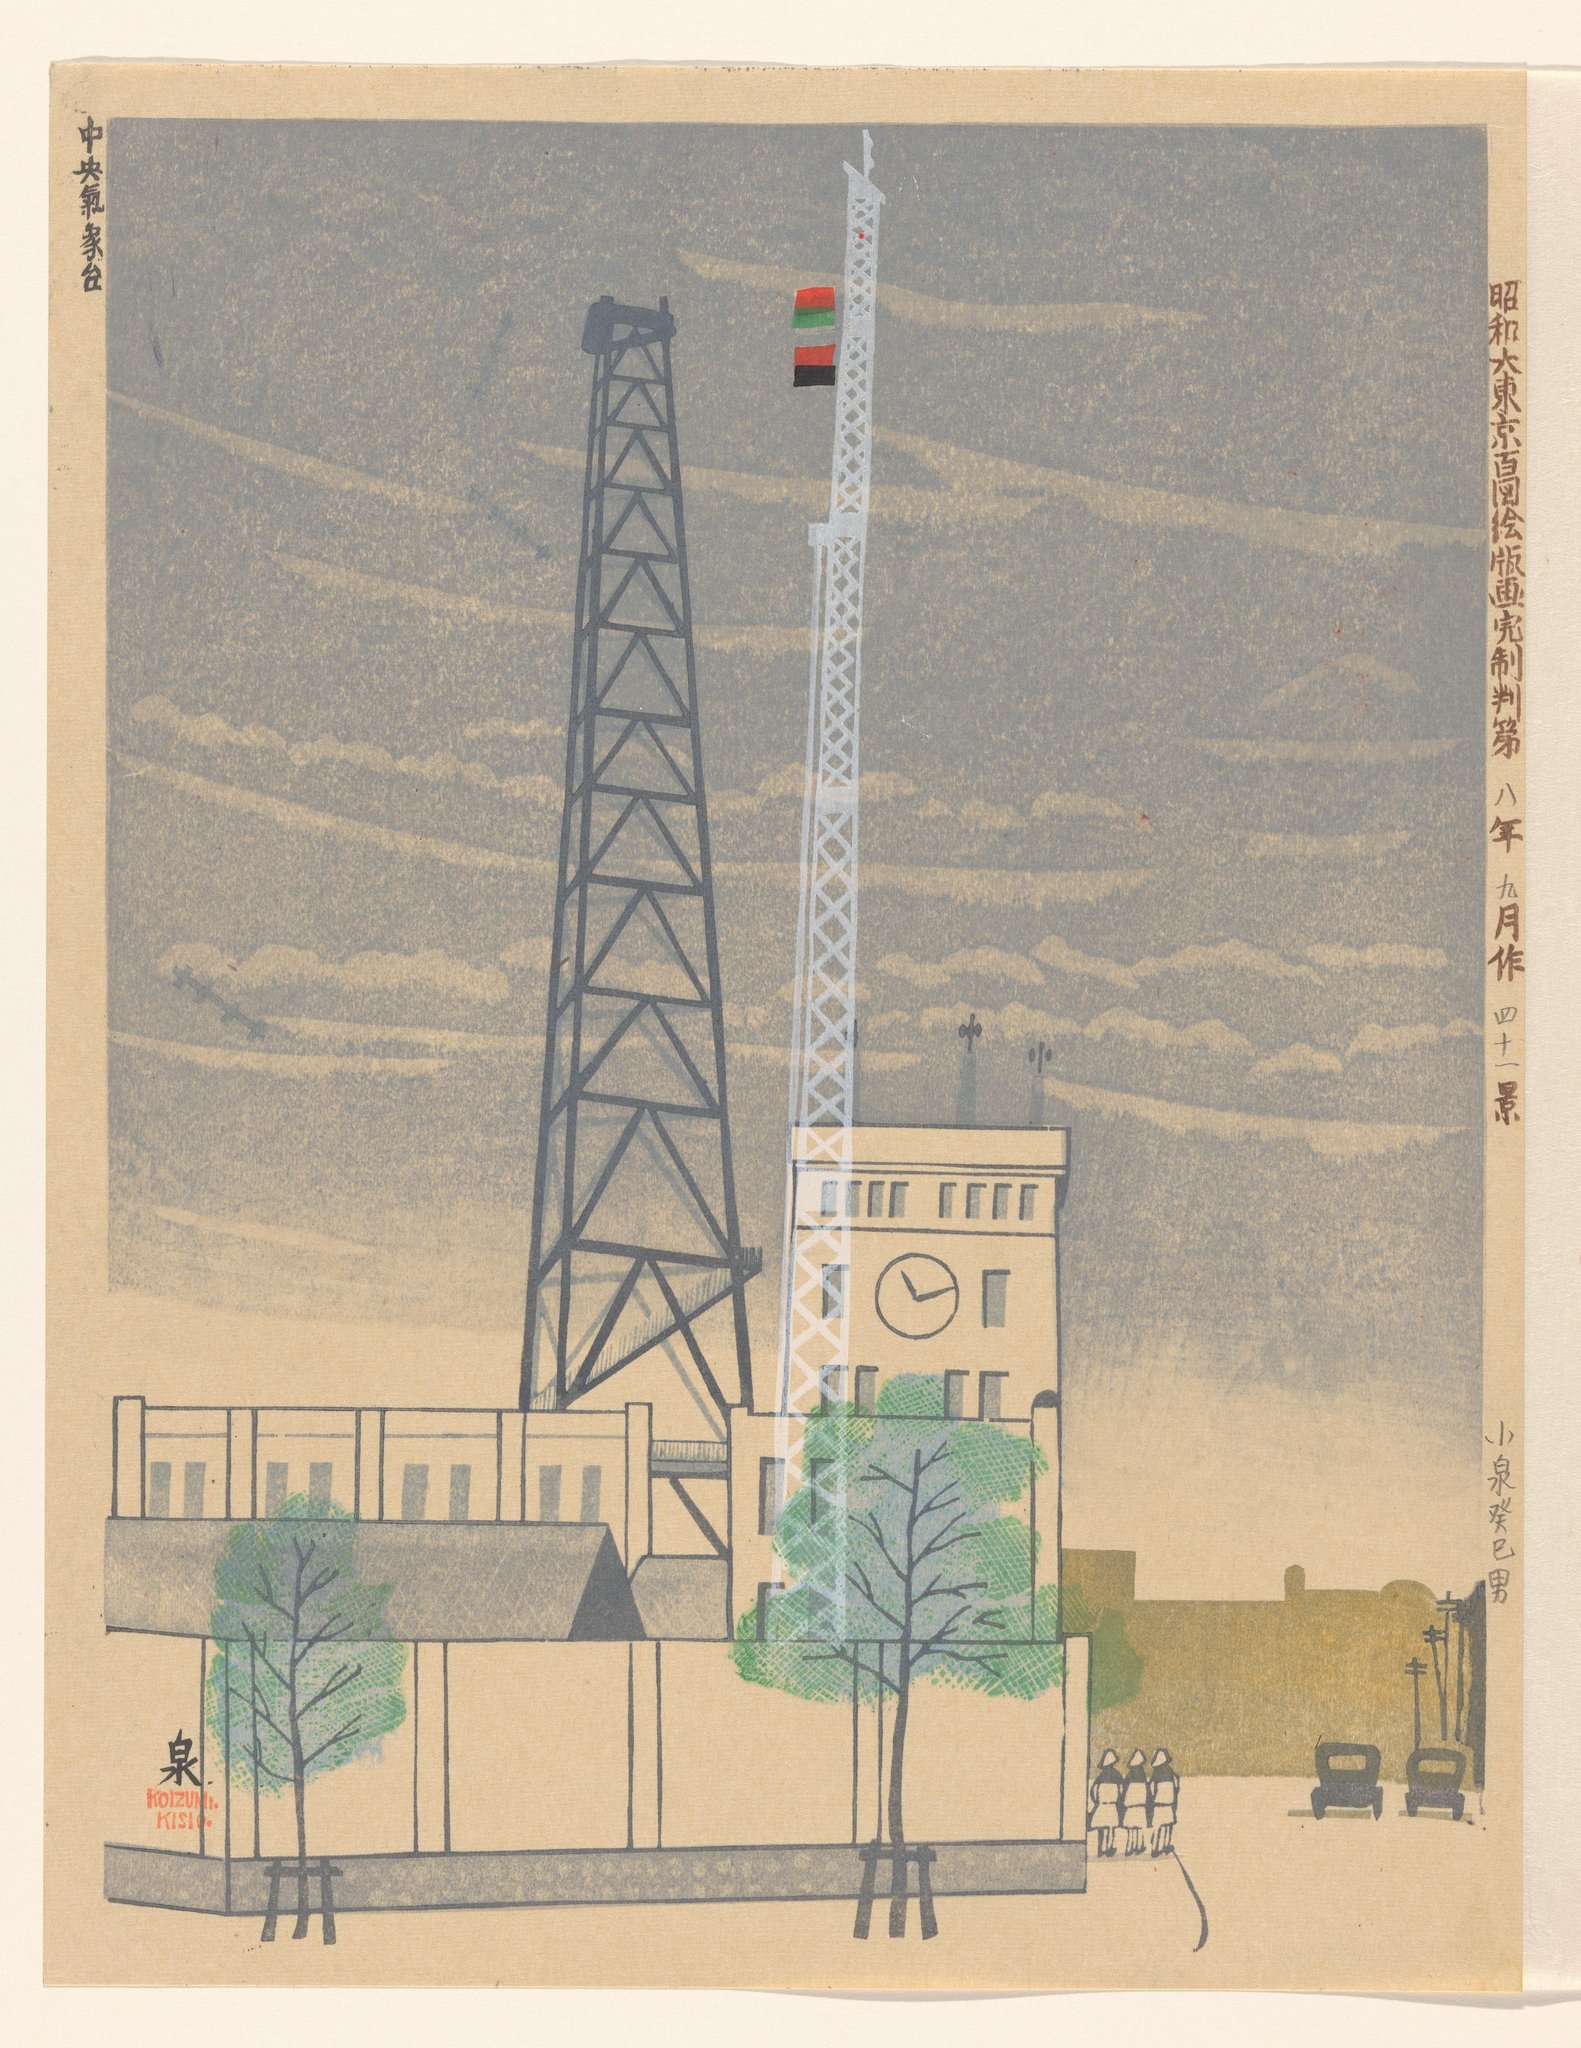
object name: print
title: Central weather station, no. 41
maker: koizumi kishio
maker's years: 1893-1945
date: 1909-1933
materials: paper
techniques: woodcut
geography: japan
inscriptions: signature: ‘泉’, seal: ‘Koizumi Kisio.’, signature: ‘小泉癸巳男’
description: De hoge zendmasten van een weerstation steken op tegen een grauwe lucht. In september 1928 begon Koizumi Kishio aan zijn ambitieuze plan om honderd landschapsprenten met scènes in Tokyo volledig zelf te ontwerpen, hiervan zelf de drukblokken te snijden en zelf de prenten te drukken. De aanleiding voor het project was grote verandering die Tokyo onderging door de verwoestende Grote Kantō-aardbeving van 1923 en de wederopbouw die daarop volgde. Kishio maakt een bewuste verwijzing naar de bekende serie ‘Honderd beroemde gezichten op Edo’ door Utagawa Hiroshige (1797–1858), met prenten van locaties in Edo—de oude benaming voor Tokyo. Kishio toont overwegend moderne gebouwen, instituten en mensen die de tijdsgeest van de jaren 1920 en 1930 weerspiegelen. Sommige prenten onthullen daarentegen een nostalgische blik op overblijfselen uit het oude Edo. Kishio verkocht de prenten aan de hand van een abonnement met een limiet van vijftig leden, die elke maand een of twee prenten zouden ontvangen. Het project begon met negen abonnementen, maar al na de tweede maand werden meerdere daarvan opgezegd en slechts vier mecenassen bleven lid tot en met de voltooiing van de serie. Hij bracht het honderdste ontwerp uit in 1937. Zijn leermeester Ishii Hakutei schreef een inleiding in 1938 die Kishio verwerkte tot een prent en toevoegde aan de set. Tussen 1939 en 1940 maakte hij nog eens negen extra ontwerpen. Met acht van deze ontwerpen verving hij oudere nummers uit de serie, mogelijk omdat hij niet tevreden was met de composities. Uiteindelijk lukte het Kishio om tien complete sets te verkopen aan de shin hanga-uitgever Watanabe Shōzaburō en liet hiervoor speciale houten dozen maken. Deze prent behoort tot een van die tien sets.